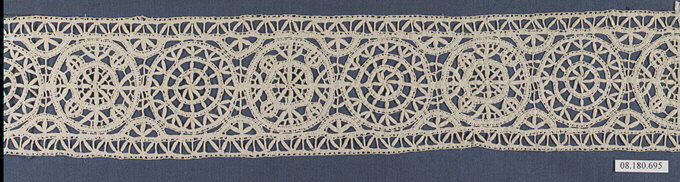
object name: border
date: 1701-1800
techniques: lace